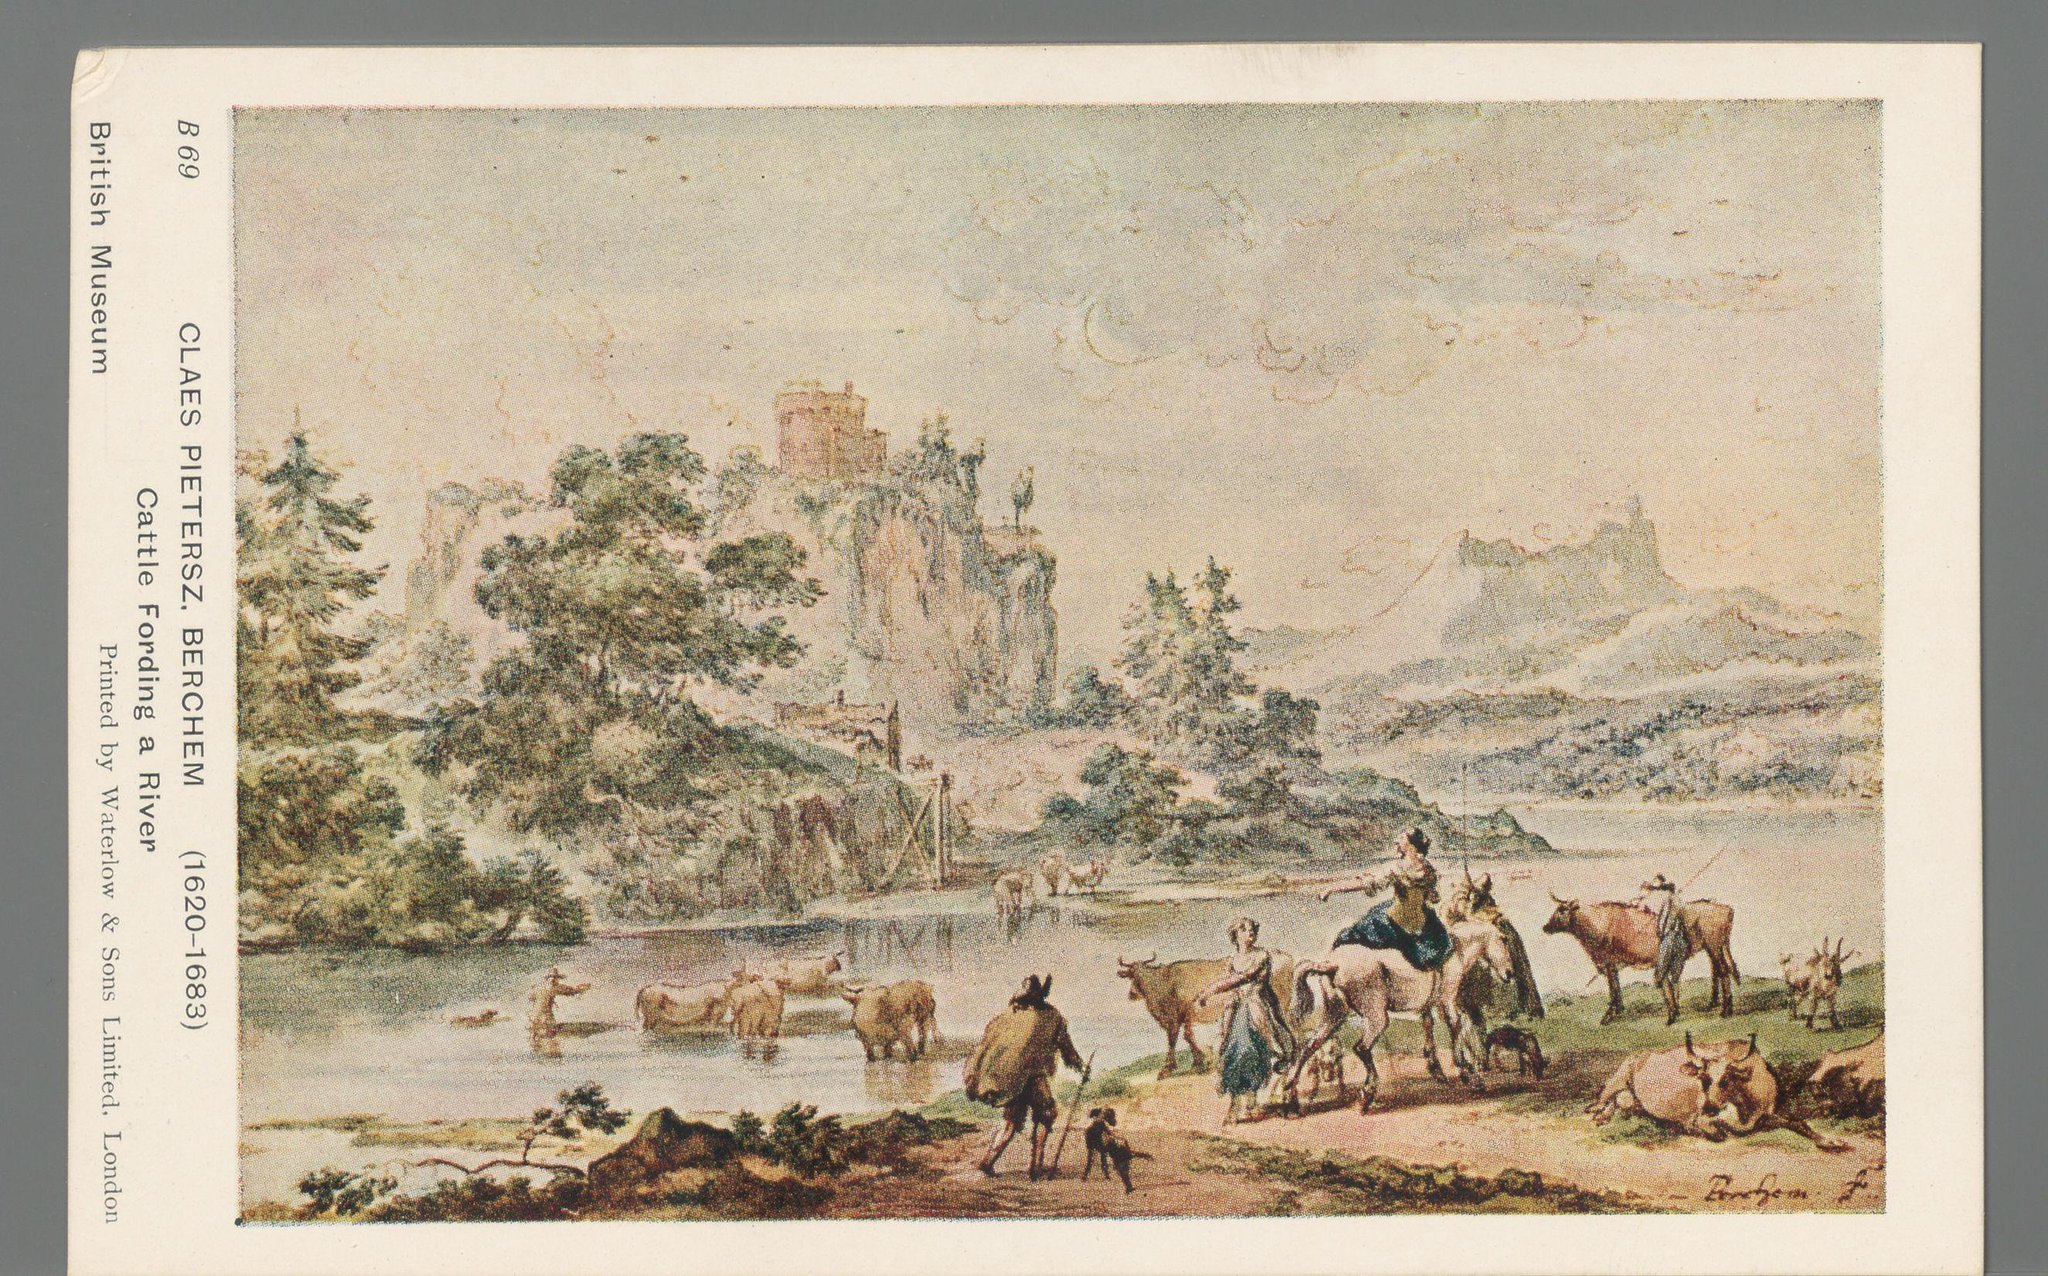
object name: photomechanical print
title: Claes Pietersz. Berchem (1620-1683). Cattle fording a river. British Museum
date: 1902-1930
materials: cardboard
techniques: color autotype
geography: london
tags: permanent exhibition, museum, picture, painting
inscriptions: collector's mark: ‘AFE v S’